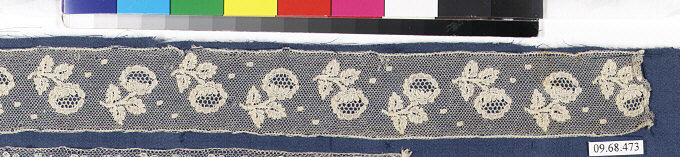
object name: insertion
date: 1801-1900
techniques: lace